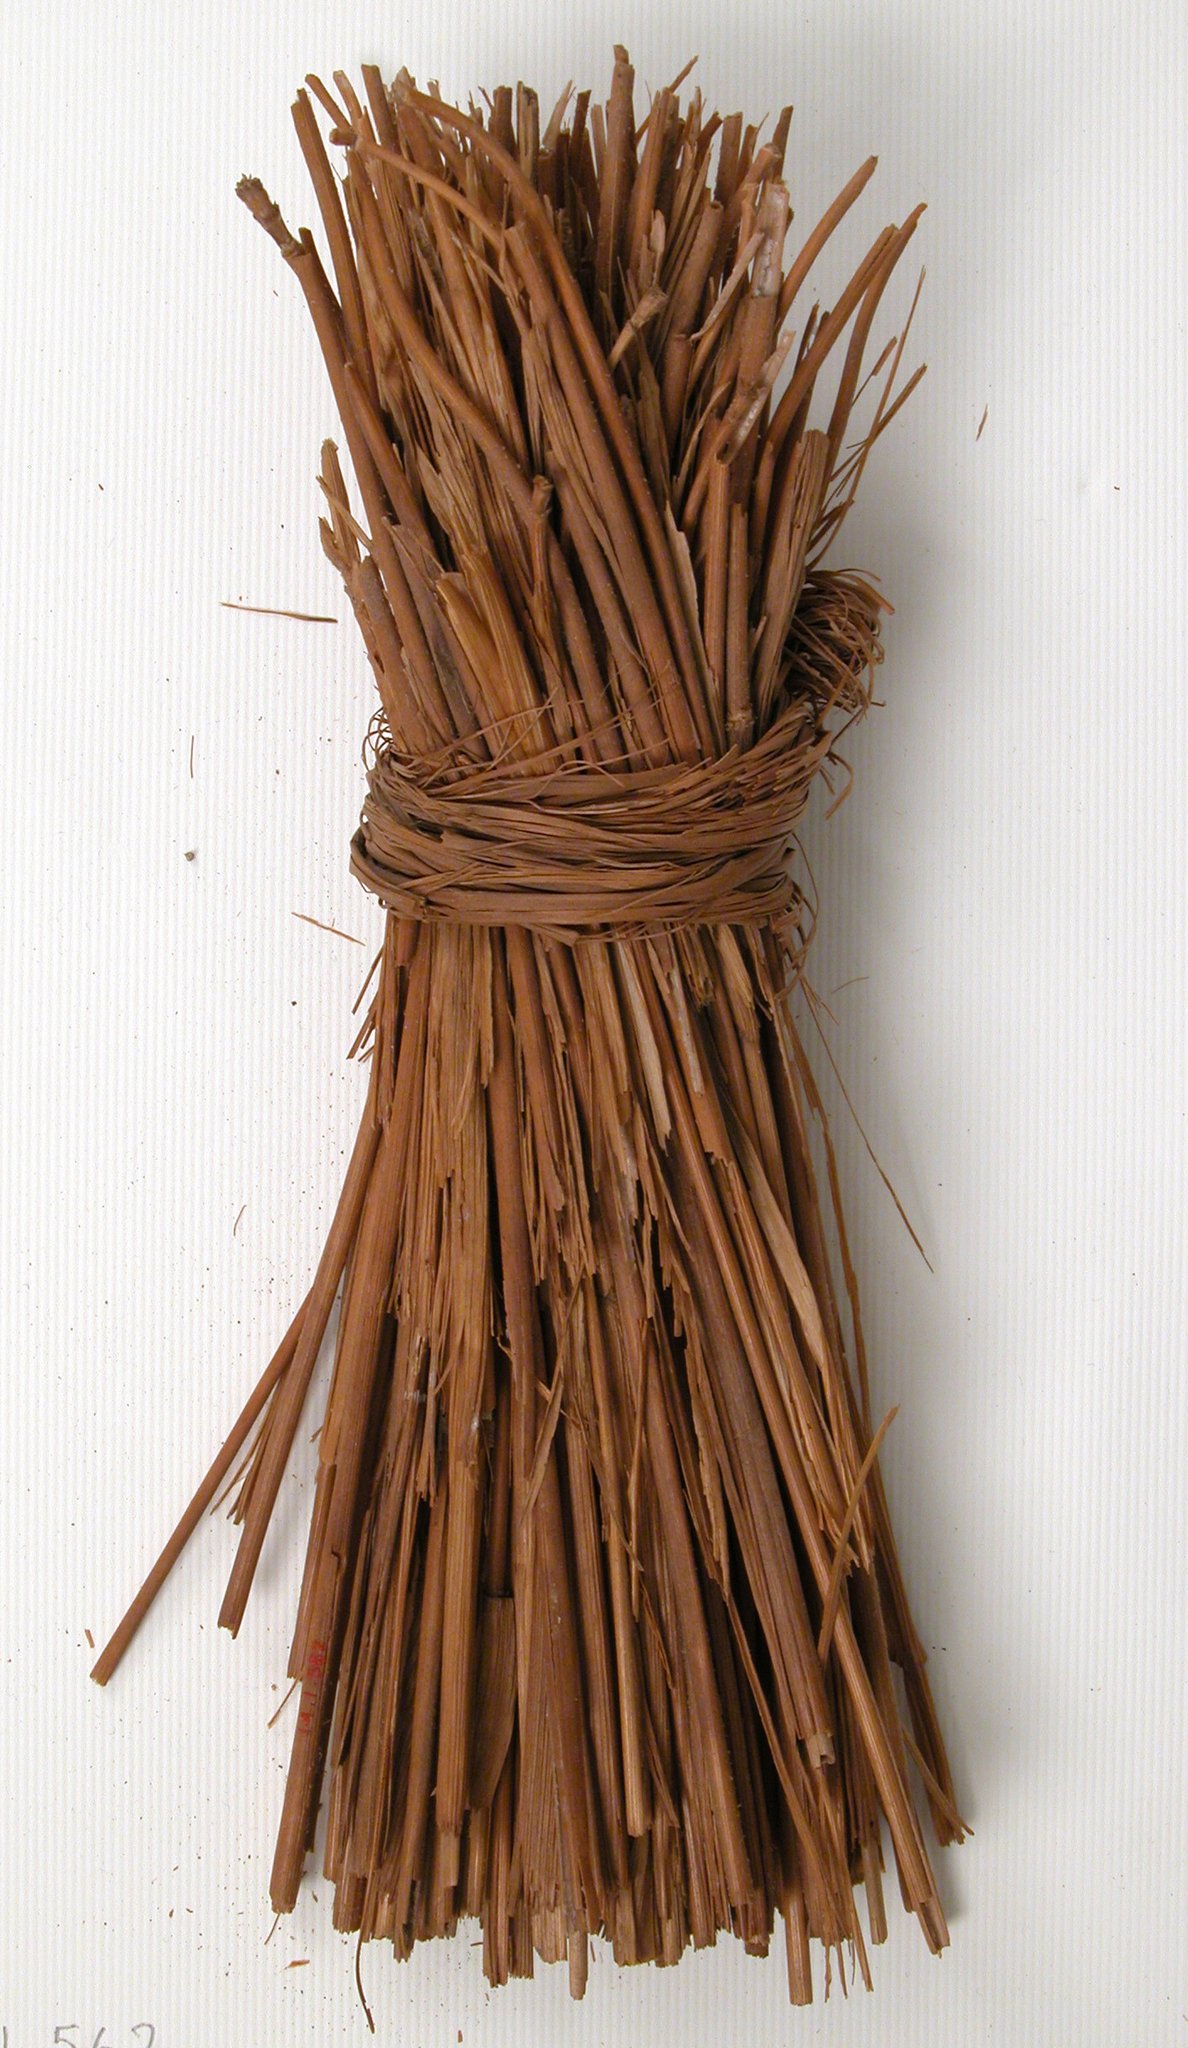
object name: grass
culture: coptic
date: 580-640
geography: egypt